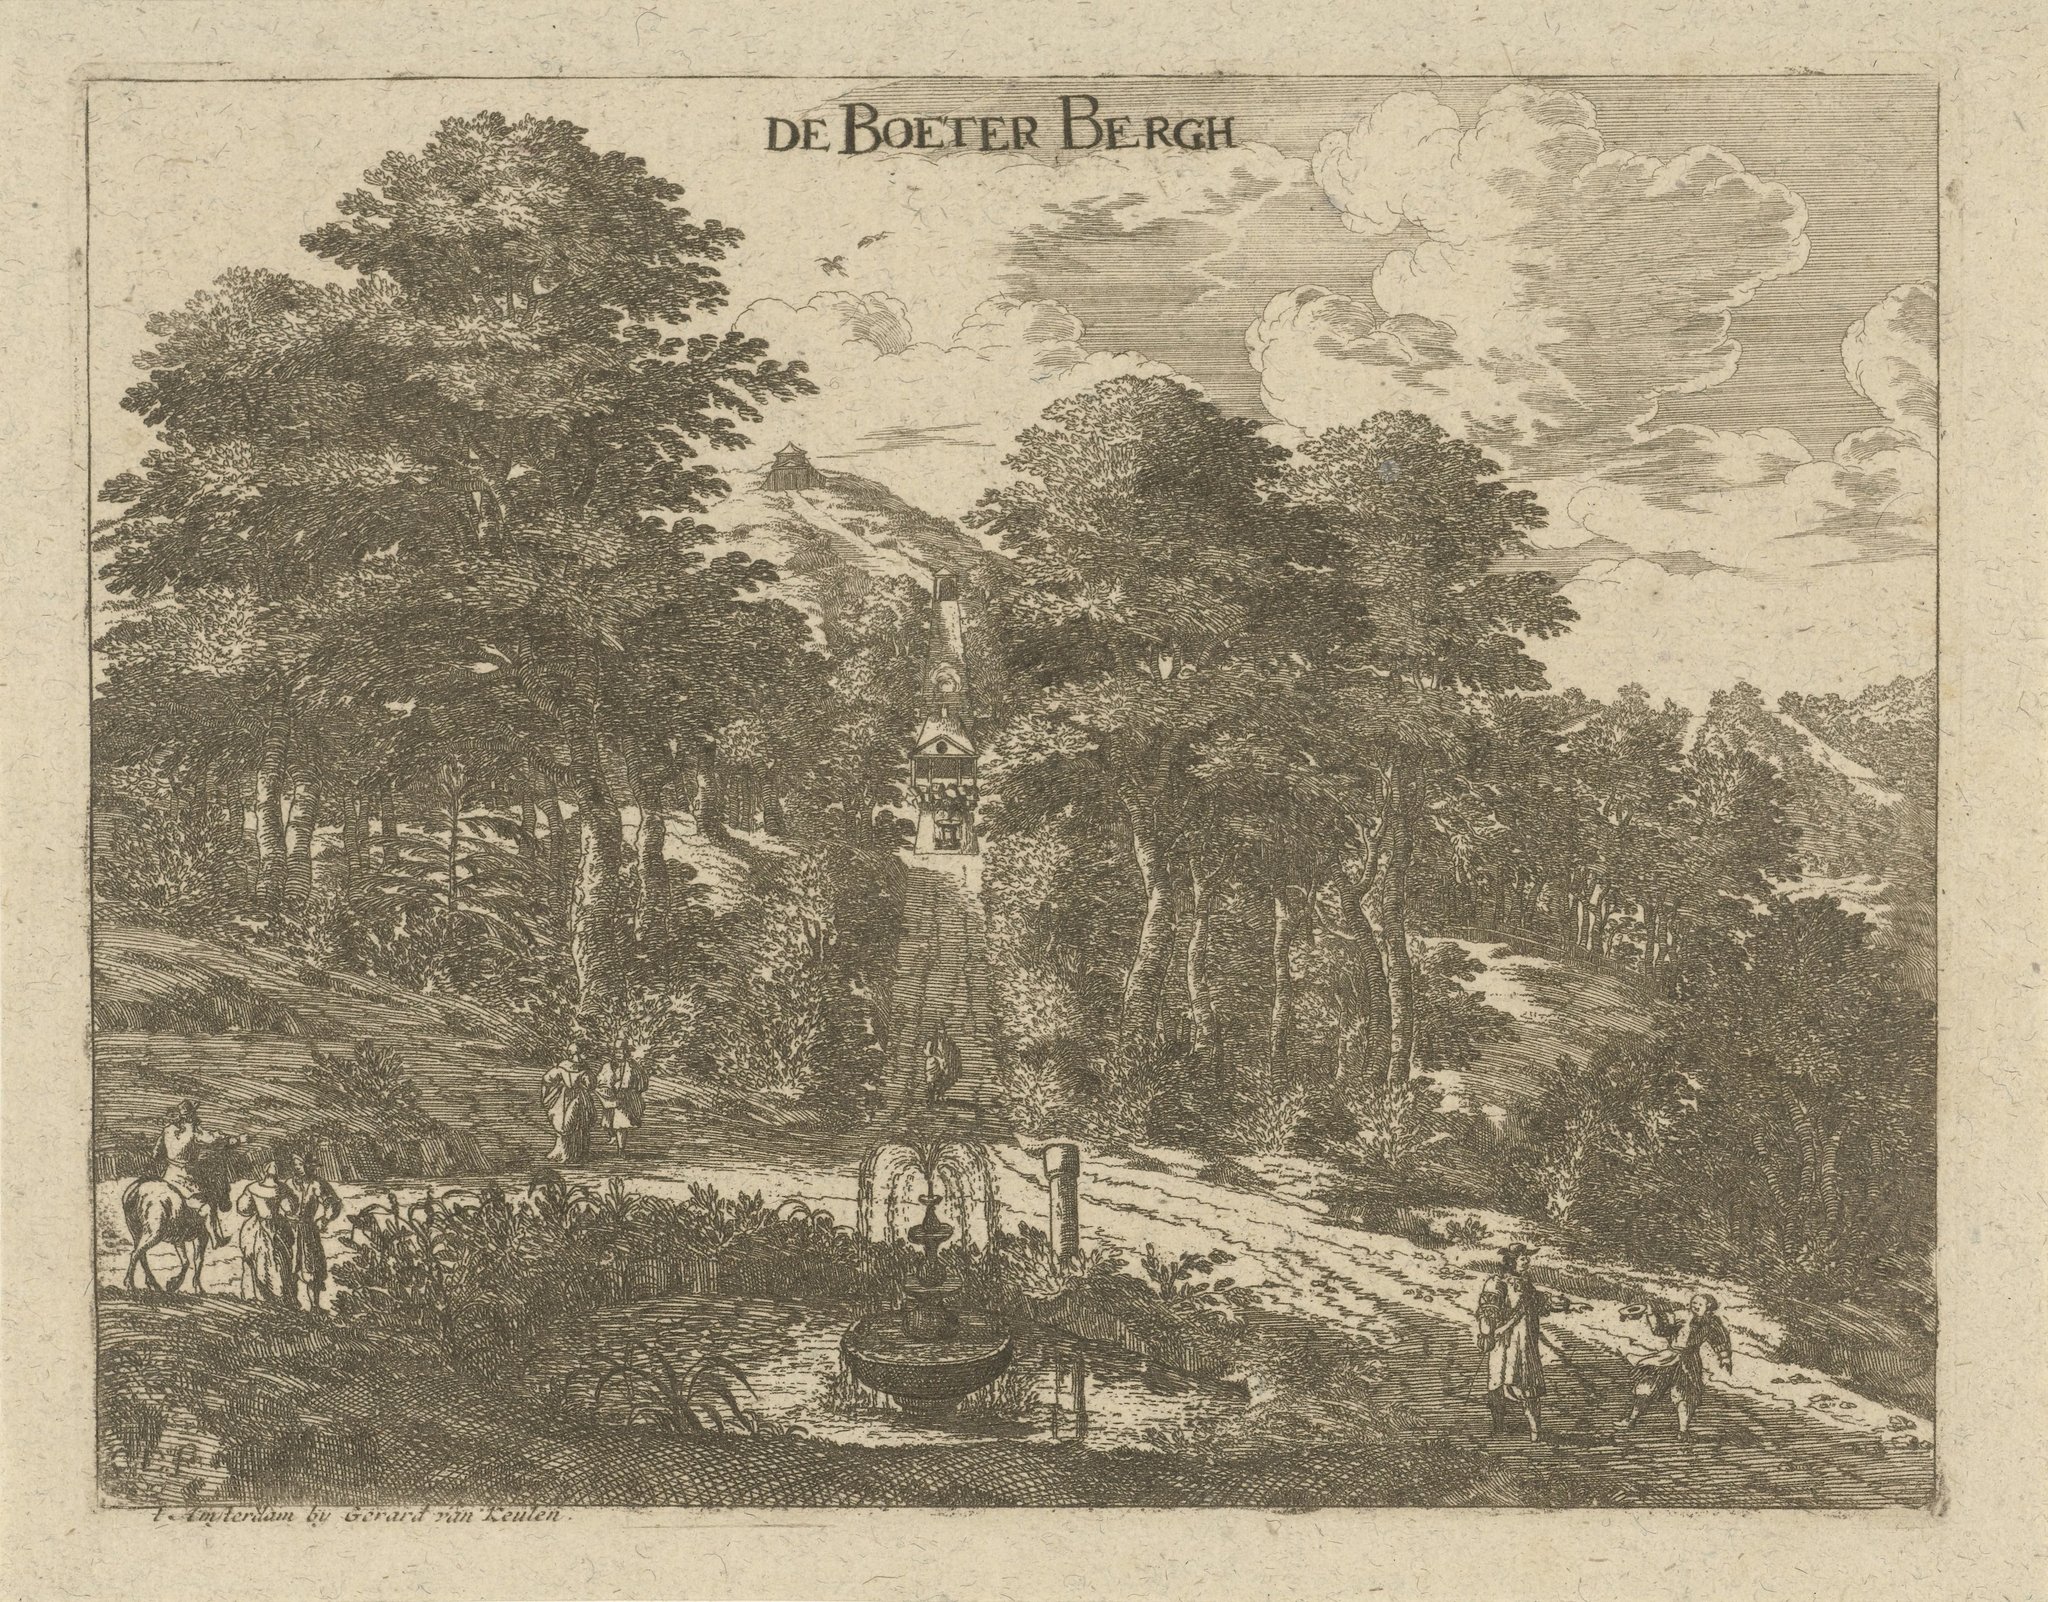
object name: print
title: De Boeter Bergh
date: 1663-1670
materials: paper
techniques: etching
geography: amsterdam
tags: landscapes, ornamental fountain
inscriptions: collector's mark: Lugt 2228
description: Landschap met op de voorgrond een vijver met fontein. Op de paden rondom de vijver en tussen de bomen zijn wandelaars afgebeeld en een man te paard. Het pad in het verlengde van de fontein leidt via drie gebouwen naar de top van een berg, waarschijnlijk de Butterberg bij Kleef.